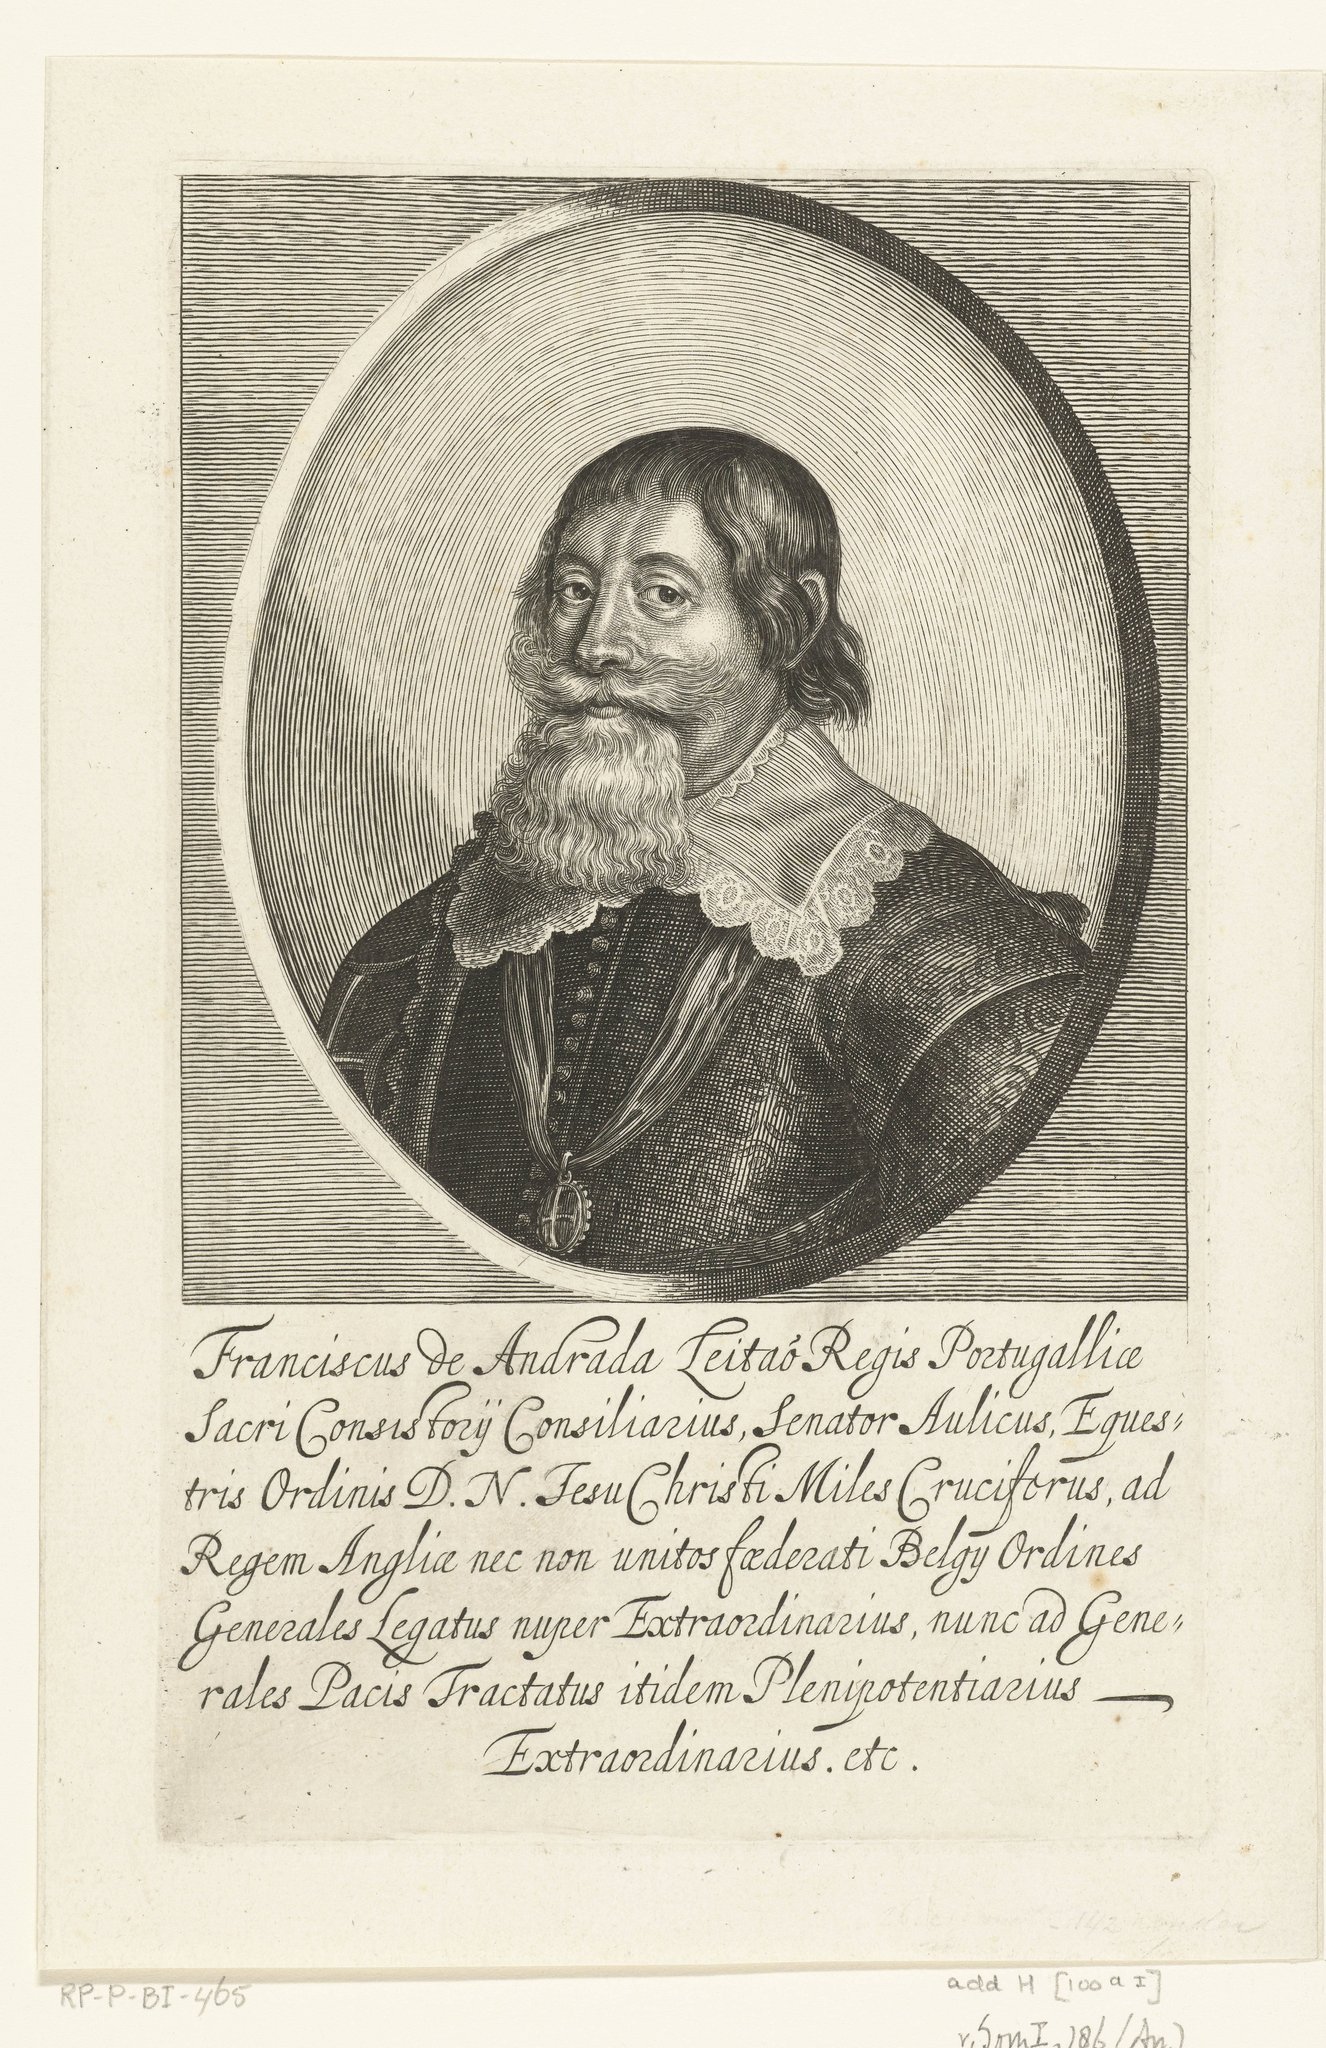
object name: print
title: Portret van Franciscus d'Andrade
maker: pieter de bailliu (i)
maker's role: print maker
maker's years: 1613-1660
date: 1623-1660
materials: paper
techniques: engraving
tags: franciscus d'andrade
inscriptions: collector's mark: Lugt 240